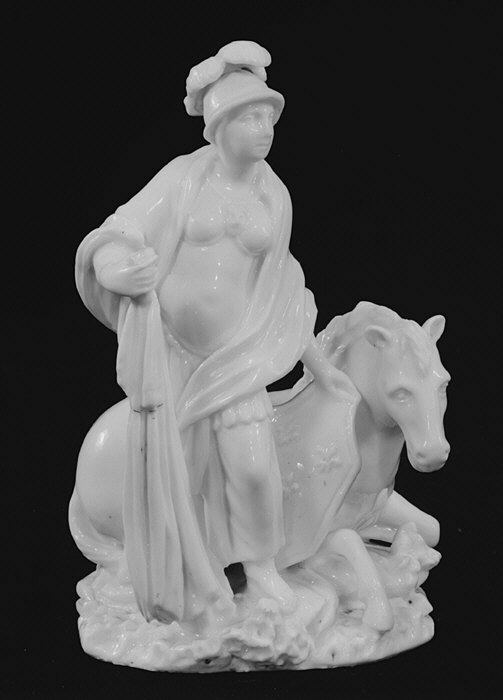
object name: figure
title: Europe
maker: mennecy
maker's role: factory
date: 1755-1760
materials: soft paste porcelain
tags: europa,horses